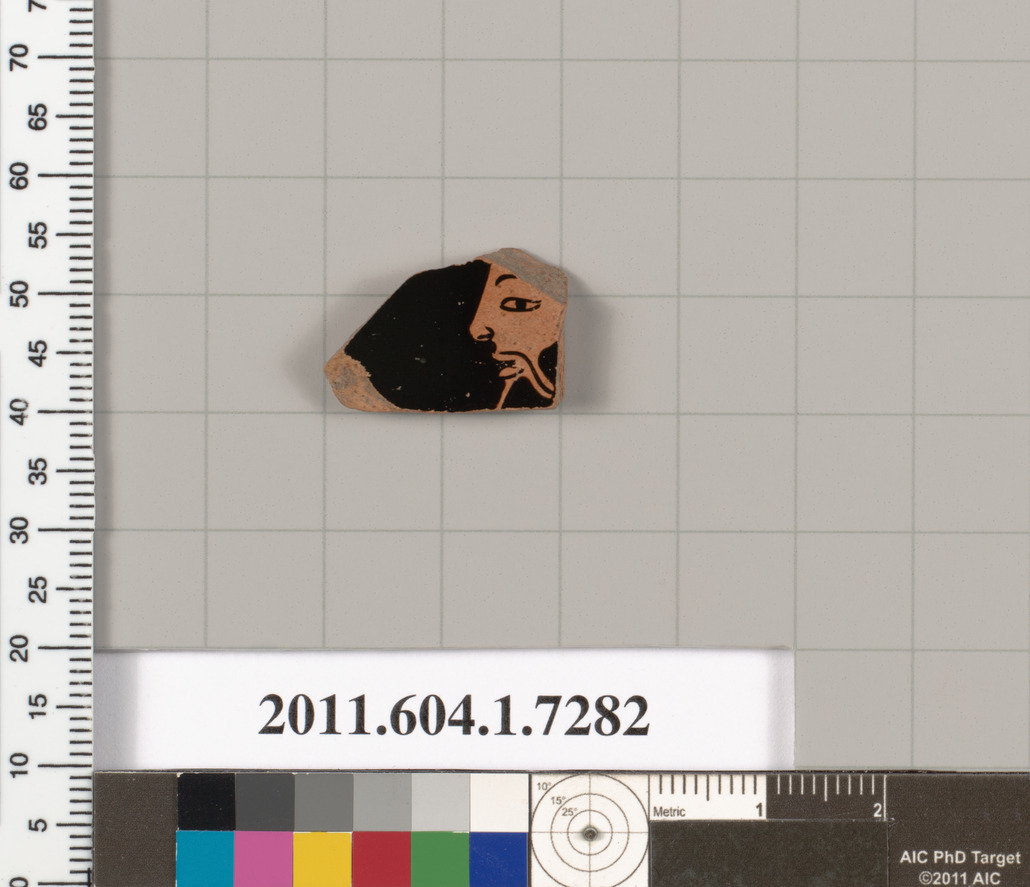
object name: kylix fragment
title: Terracotta fragment of a kylix (drinking cup)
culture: greek, attic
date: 500-480 BCE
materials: terracotta